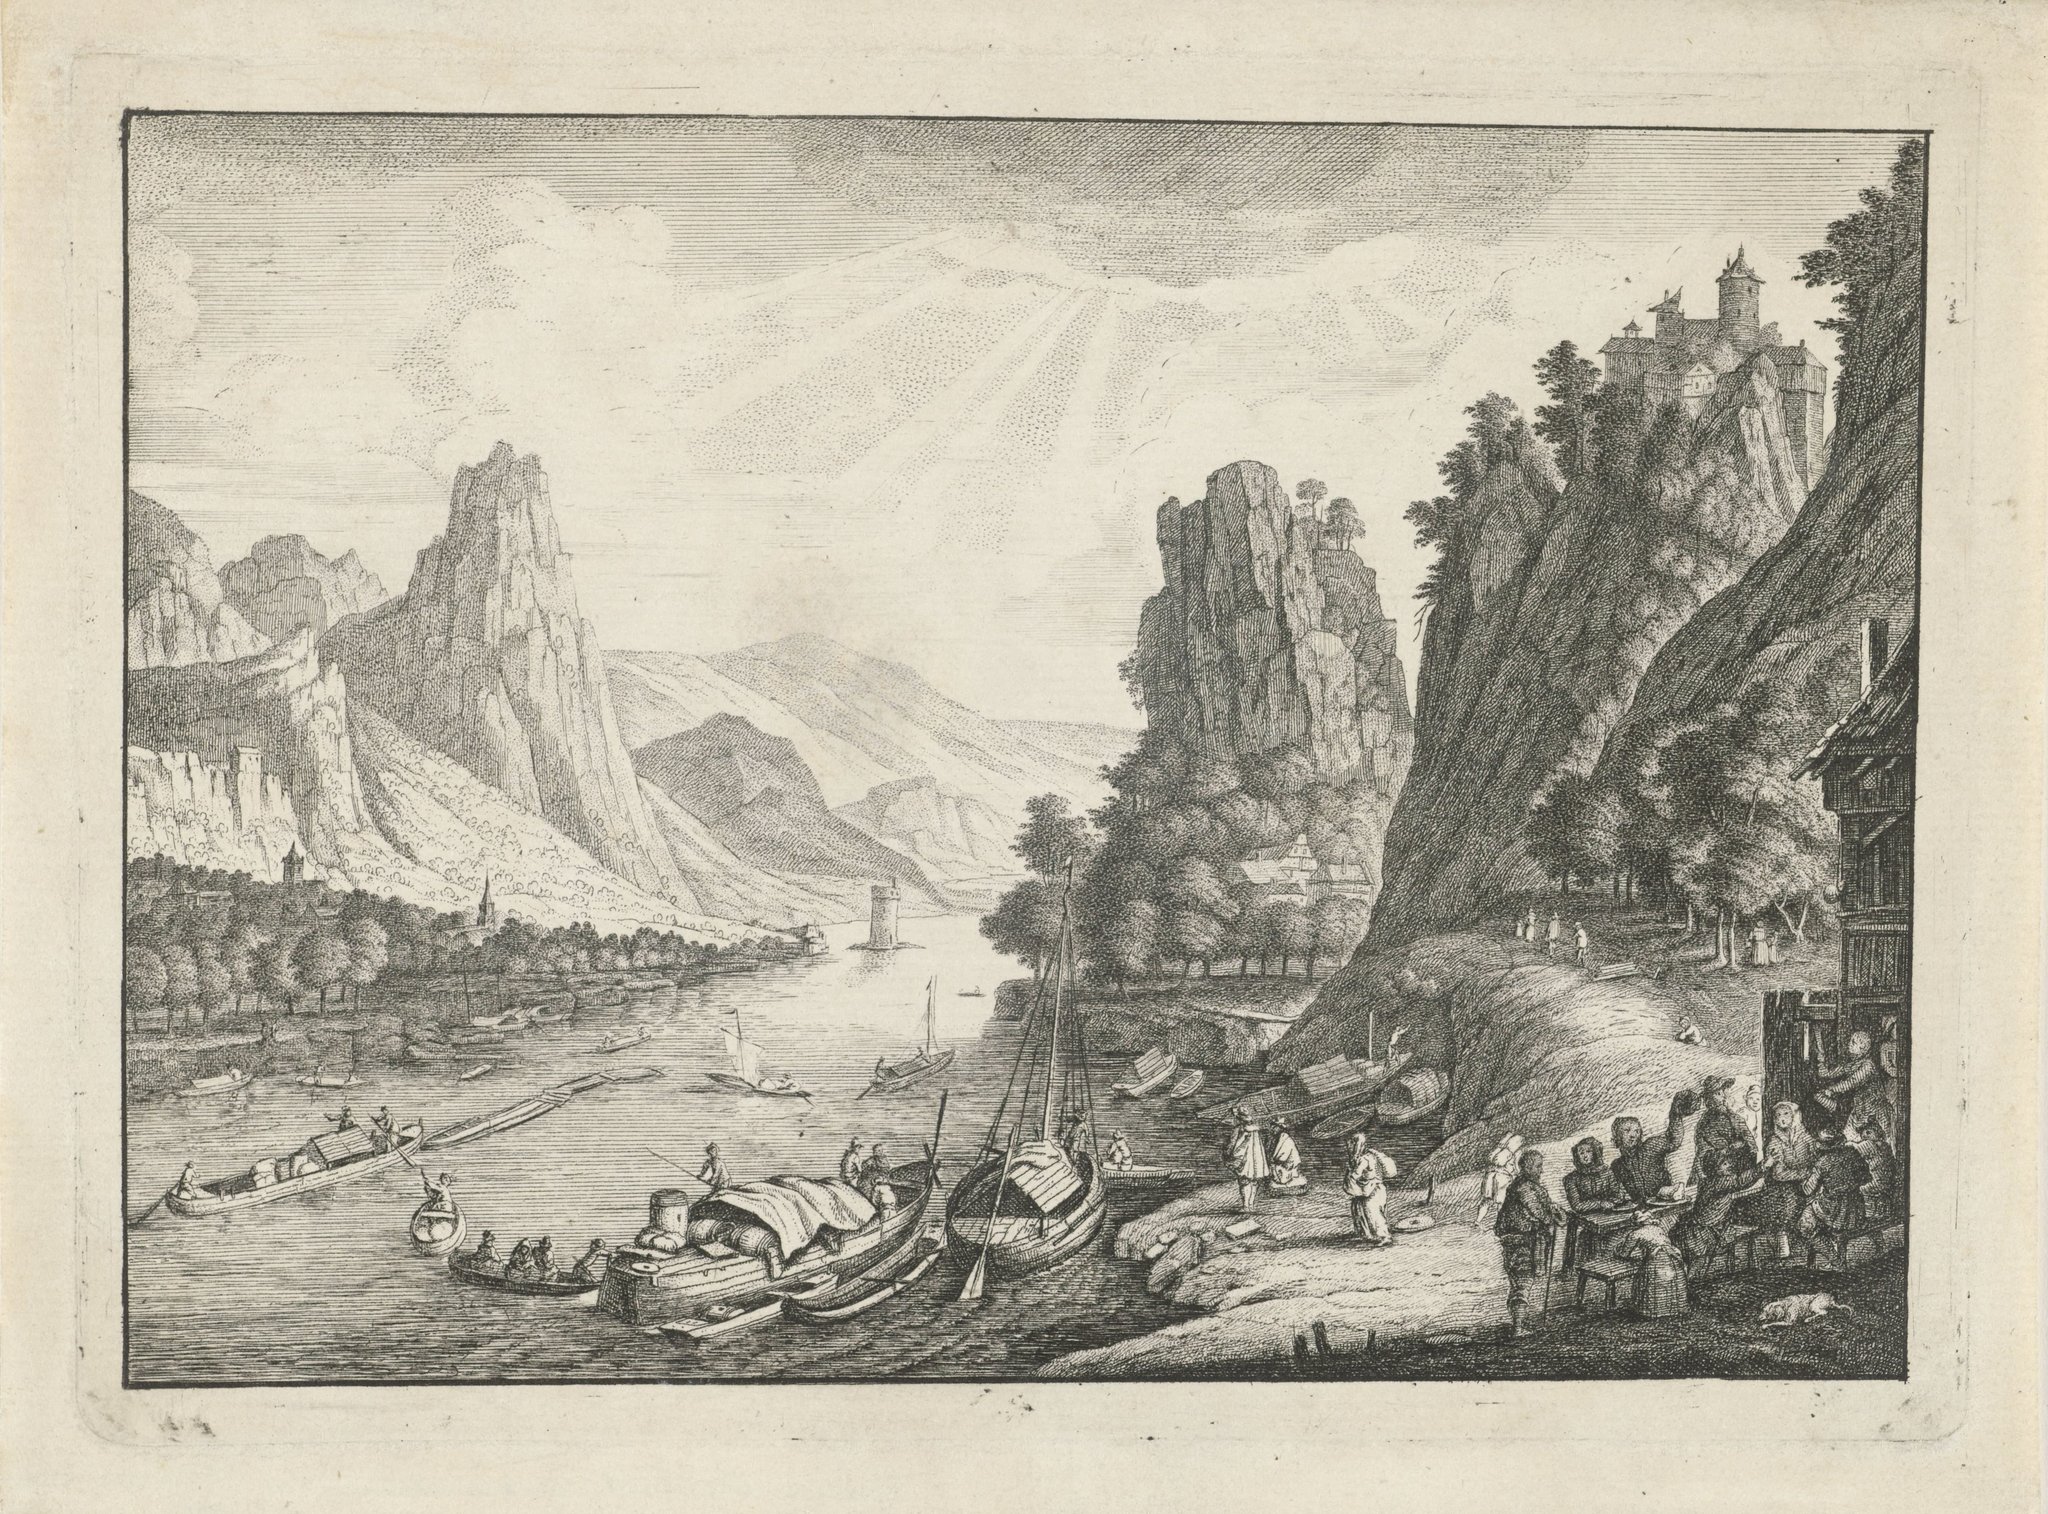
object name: print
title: Rivierlandschap met bootverkeer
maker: gerard melder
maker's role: painter, print maker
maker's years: 1693-1754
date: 1703-1754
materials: paper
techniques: etching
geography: amsterdam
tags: river, traffic on the water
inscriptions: collector's mark: Lugt 2165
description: Rivierlandschap met hoge rotsen langs de oevers. Op de rivier varen schepen en bootjes. Op de achtergrond een eiland met een toren. Rechts aan de oever een herberg met gasten die buiten aan een tafel zitten te eten.